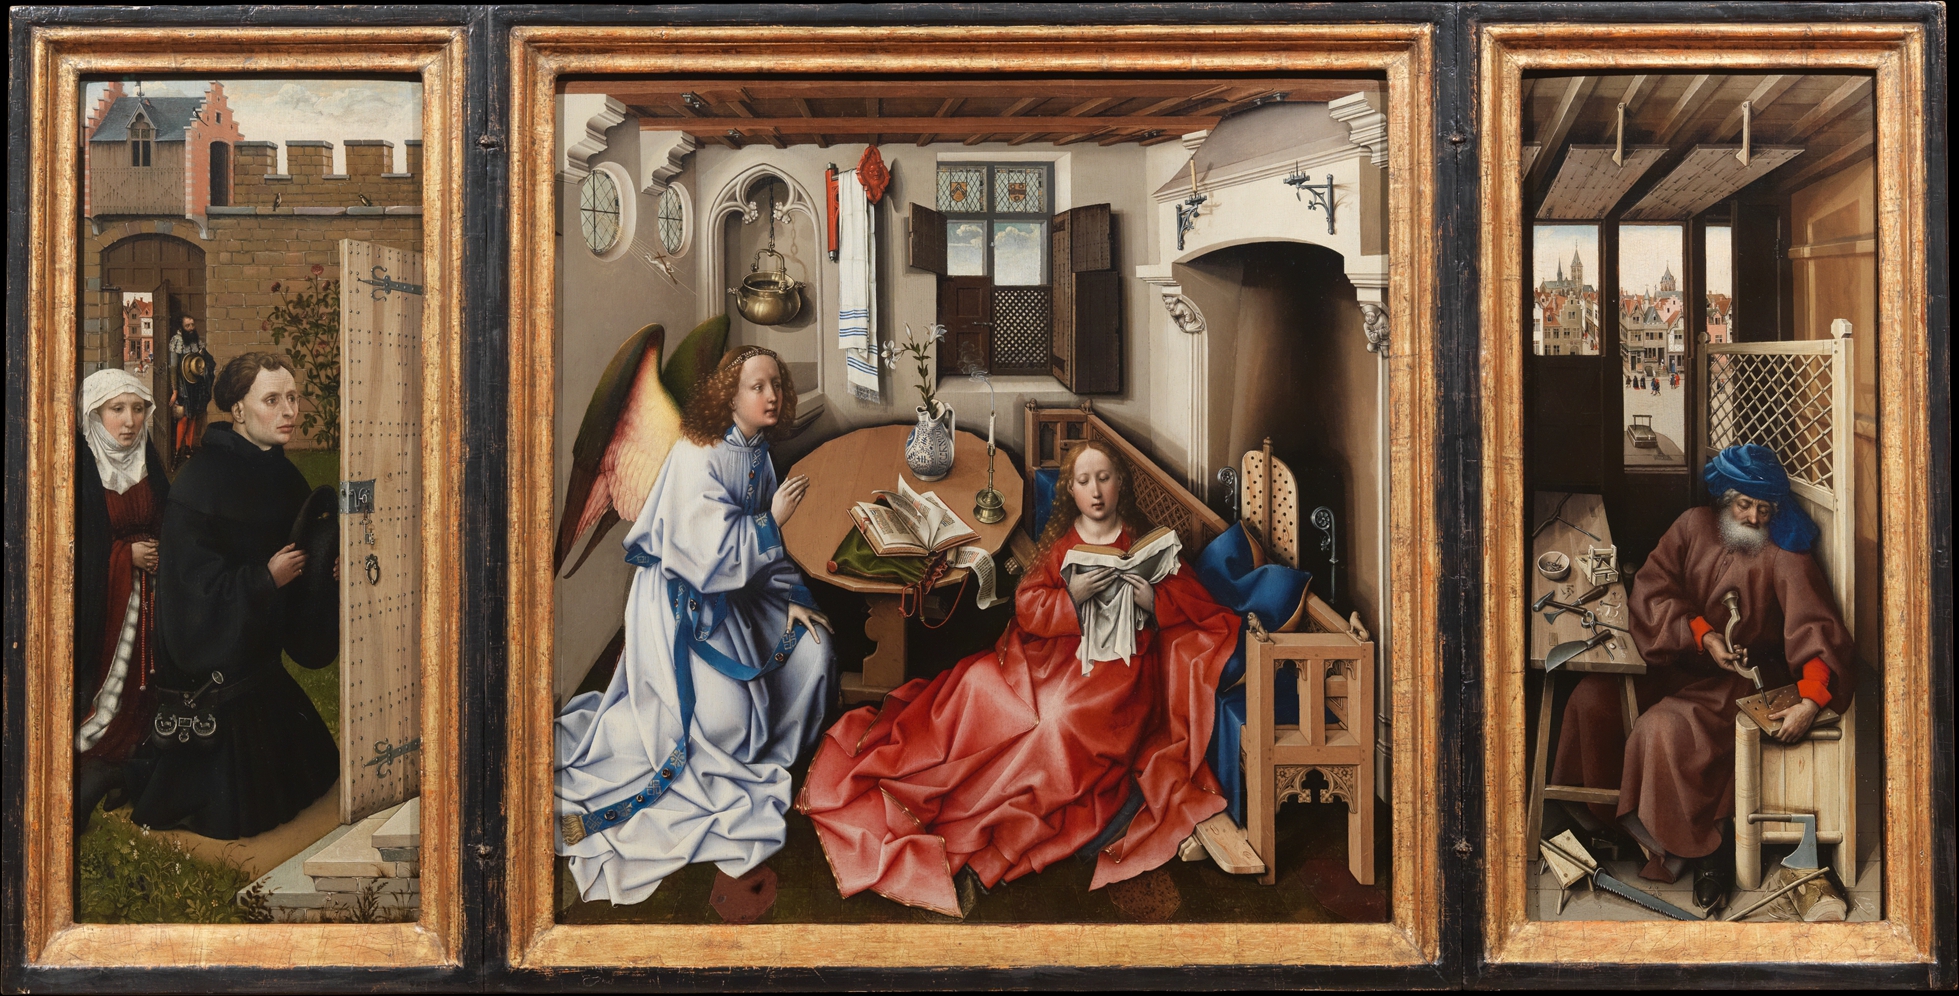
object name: altarpiece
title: Annunciation Triptych (Merode Altarpiece)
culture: dutch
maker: robert campin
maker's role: artist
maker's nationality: netherlandish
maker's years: 1375-1444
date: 1427-1432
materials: wood, oil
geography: south netherlands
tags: interiors,men,women,reading,saint joseph,virgin mary,archangel gabriel,annunciation